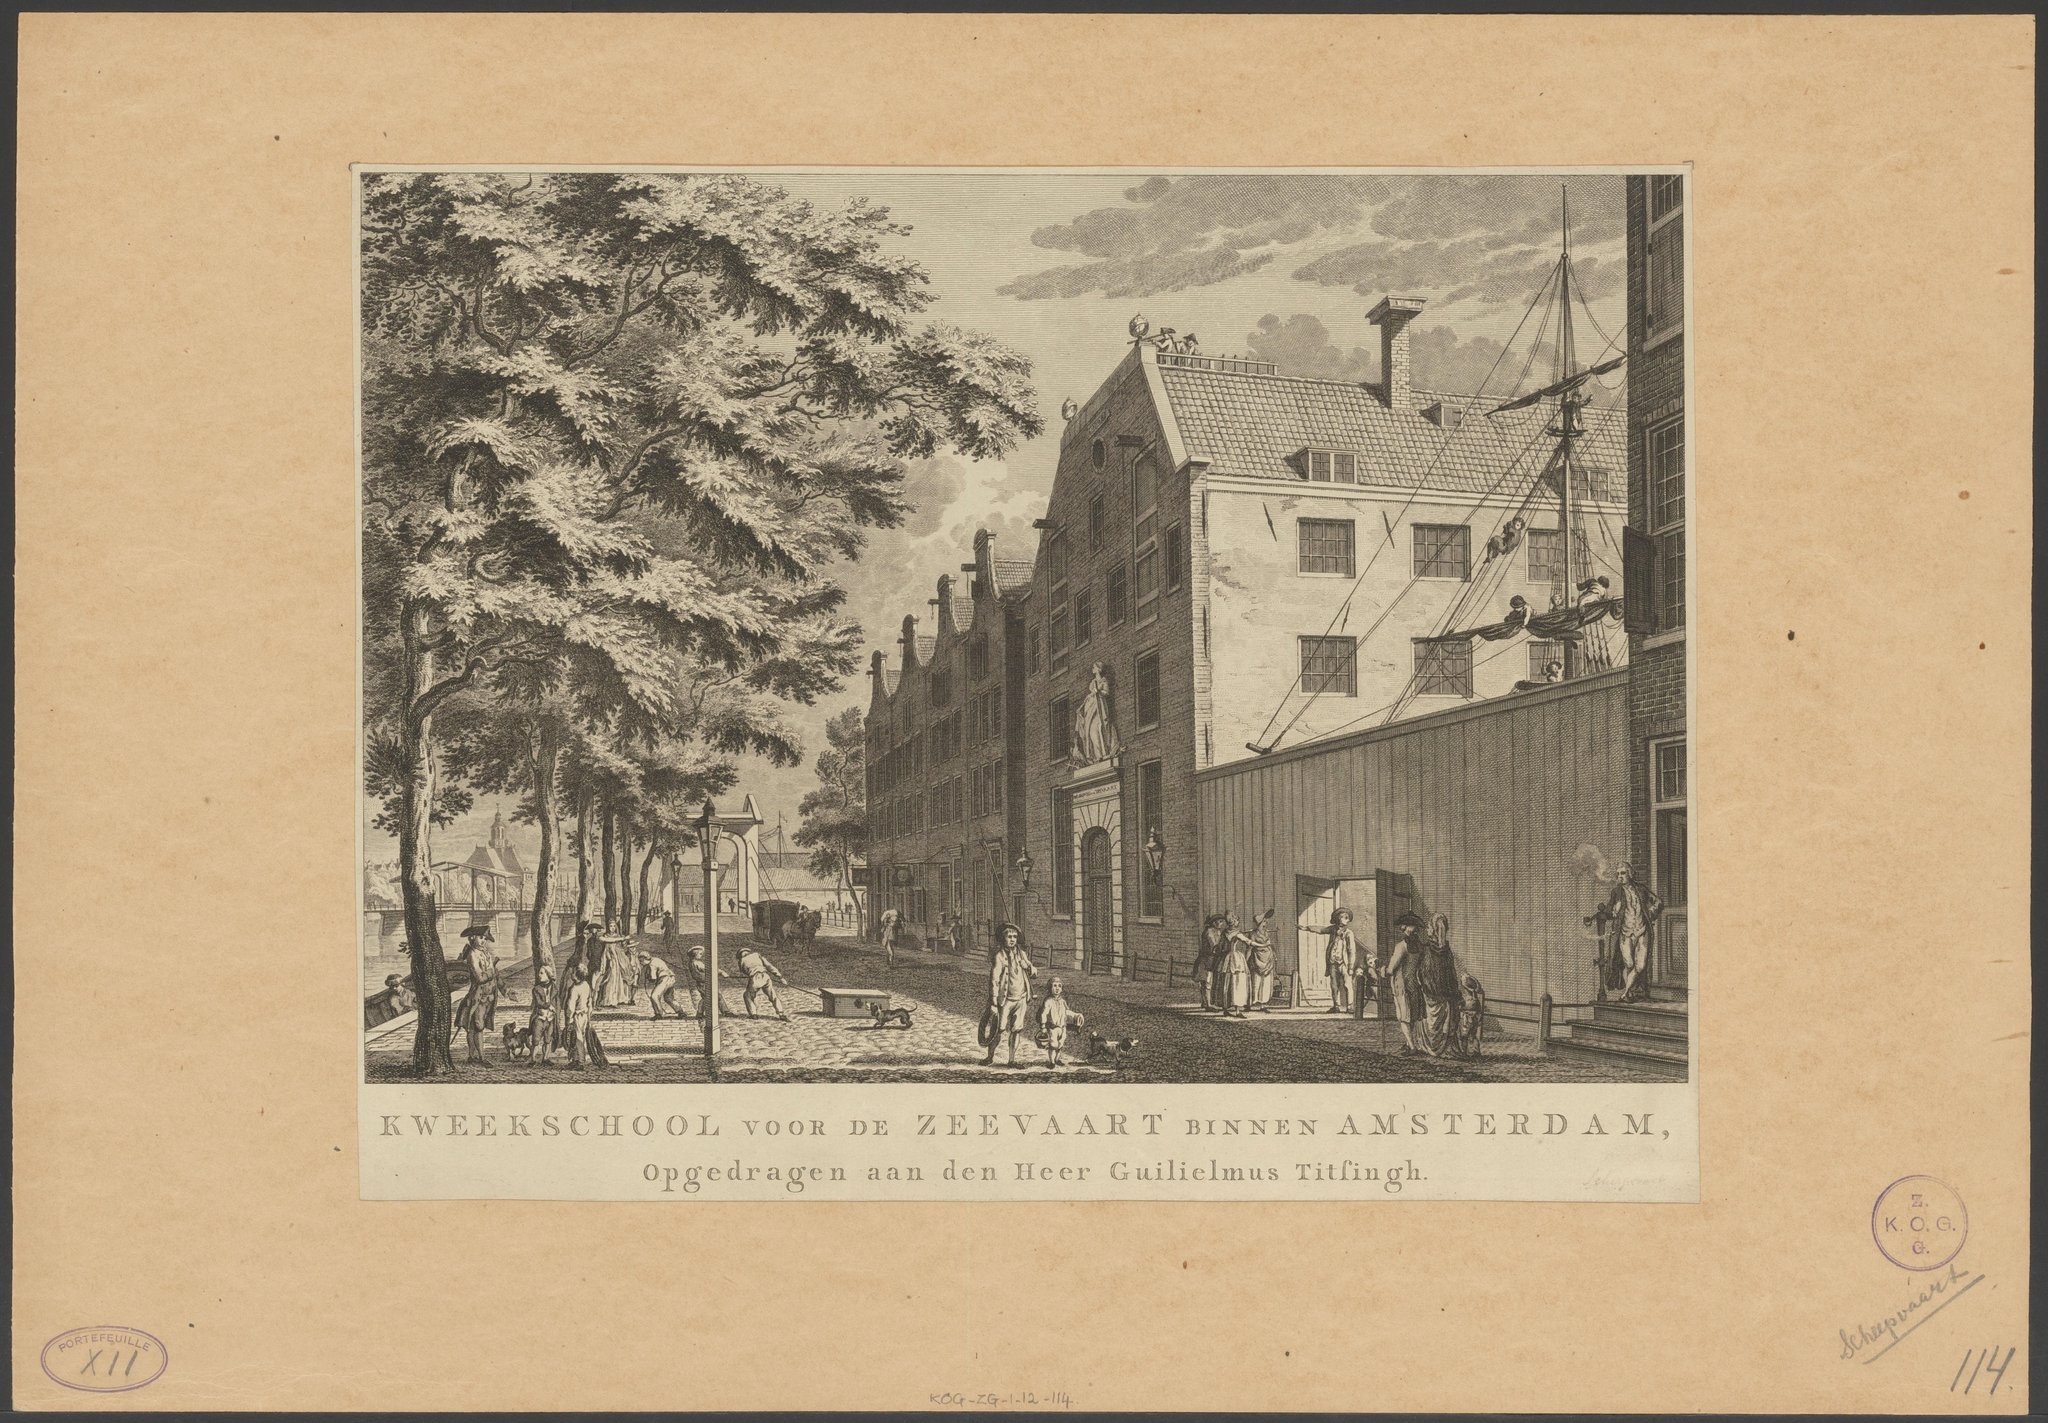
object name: print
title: Gezicht op de Kweekschool voor de Zeevaart te Amsterdam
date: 1784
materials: paper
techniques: etching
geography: amsterdam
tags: secondary education (+ building ~ education, tuition), canal, street, amsterdam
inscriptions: collector's mark: Lugt 1641, stamp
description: Gezicht op de Kweekschool voor de Zeevaart, gelegen aan de Buitenkant te Amsterdam, opgericht december 1784. De prent is opgedragen aan Willem Titsingh, initiatiefnemer tot de oprichting van de school. Onderwerpsrubrieken binnen de Atlas Zeden en Gewoonten: Handel, Nijverheid en Verkeer, Scheepsvaart.